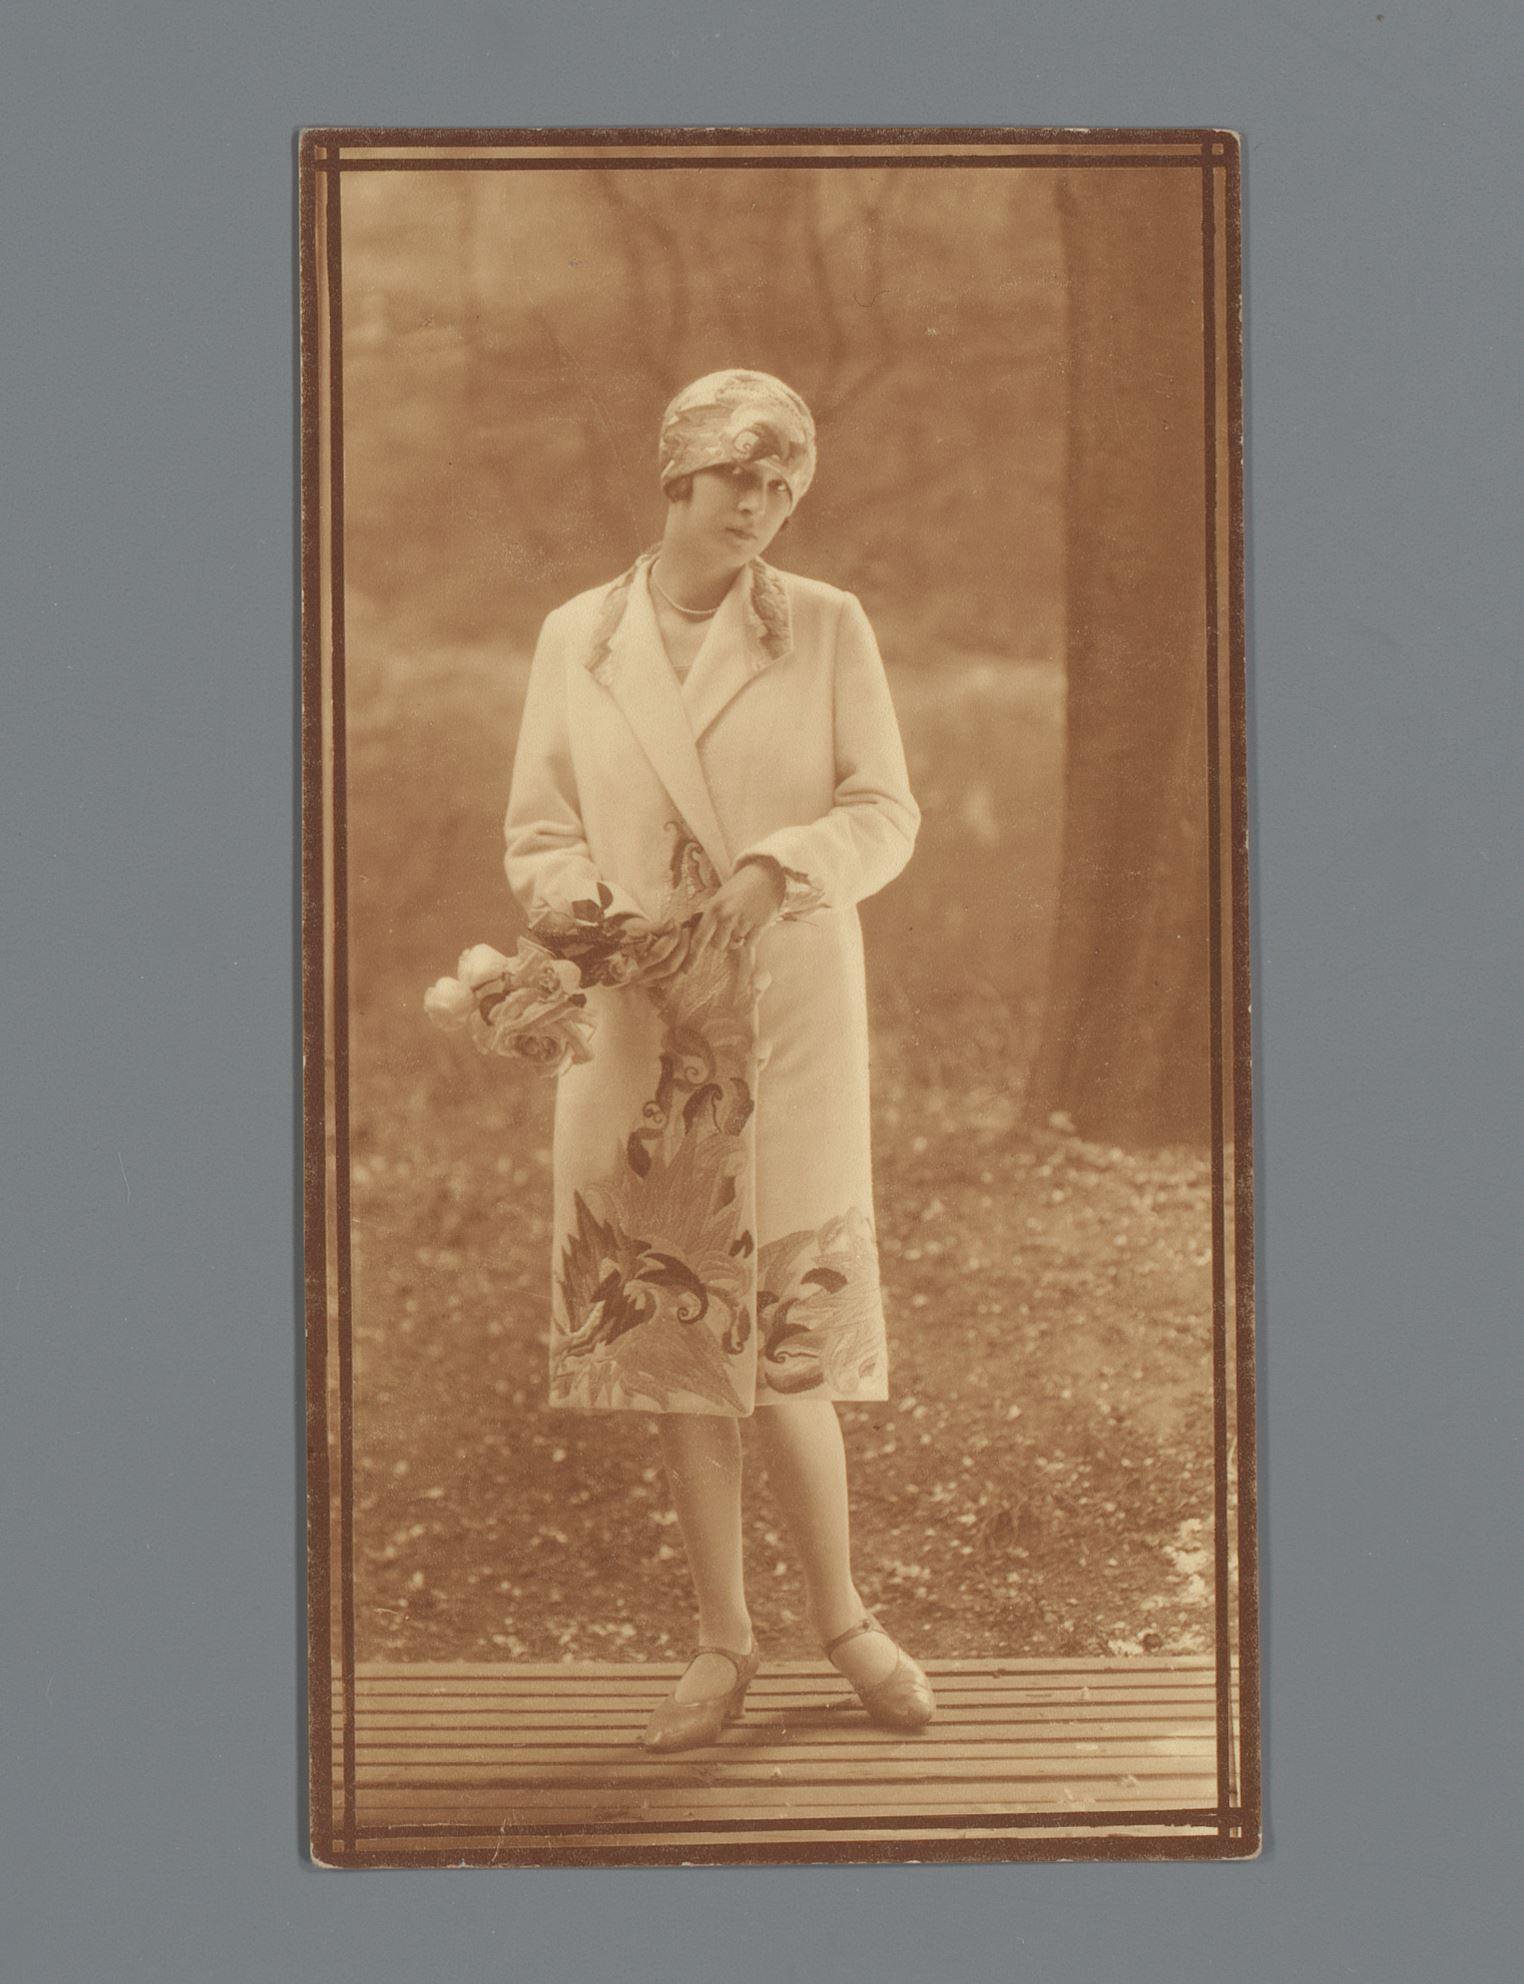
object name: photograph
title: Model met geborduurde mantel en muts van de Wiener Werkstätte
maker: Anonymous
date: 1920-1930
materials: photographic support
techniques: gelatin silver print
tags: fashion plates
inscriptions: stamp: ‘[...] WIEN’, inscription: ‘te 115.’, number: ‘No 26’, stamp, inscription: ‘130-26’